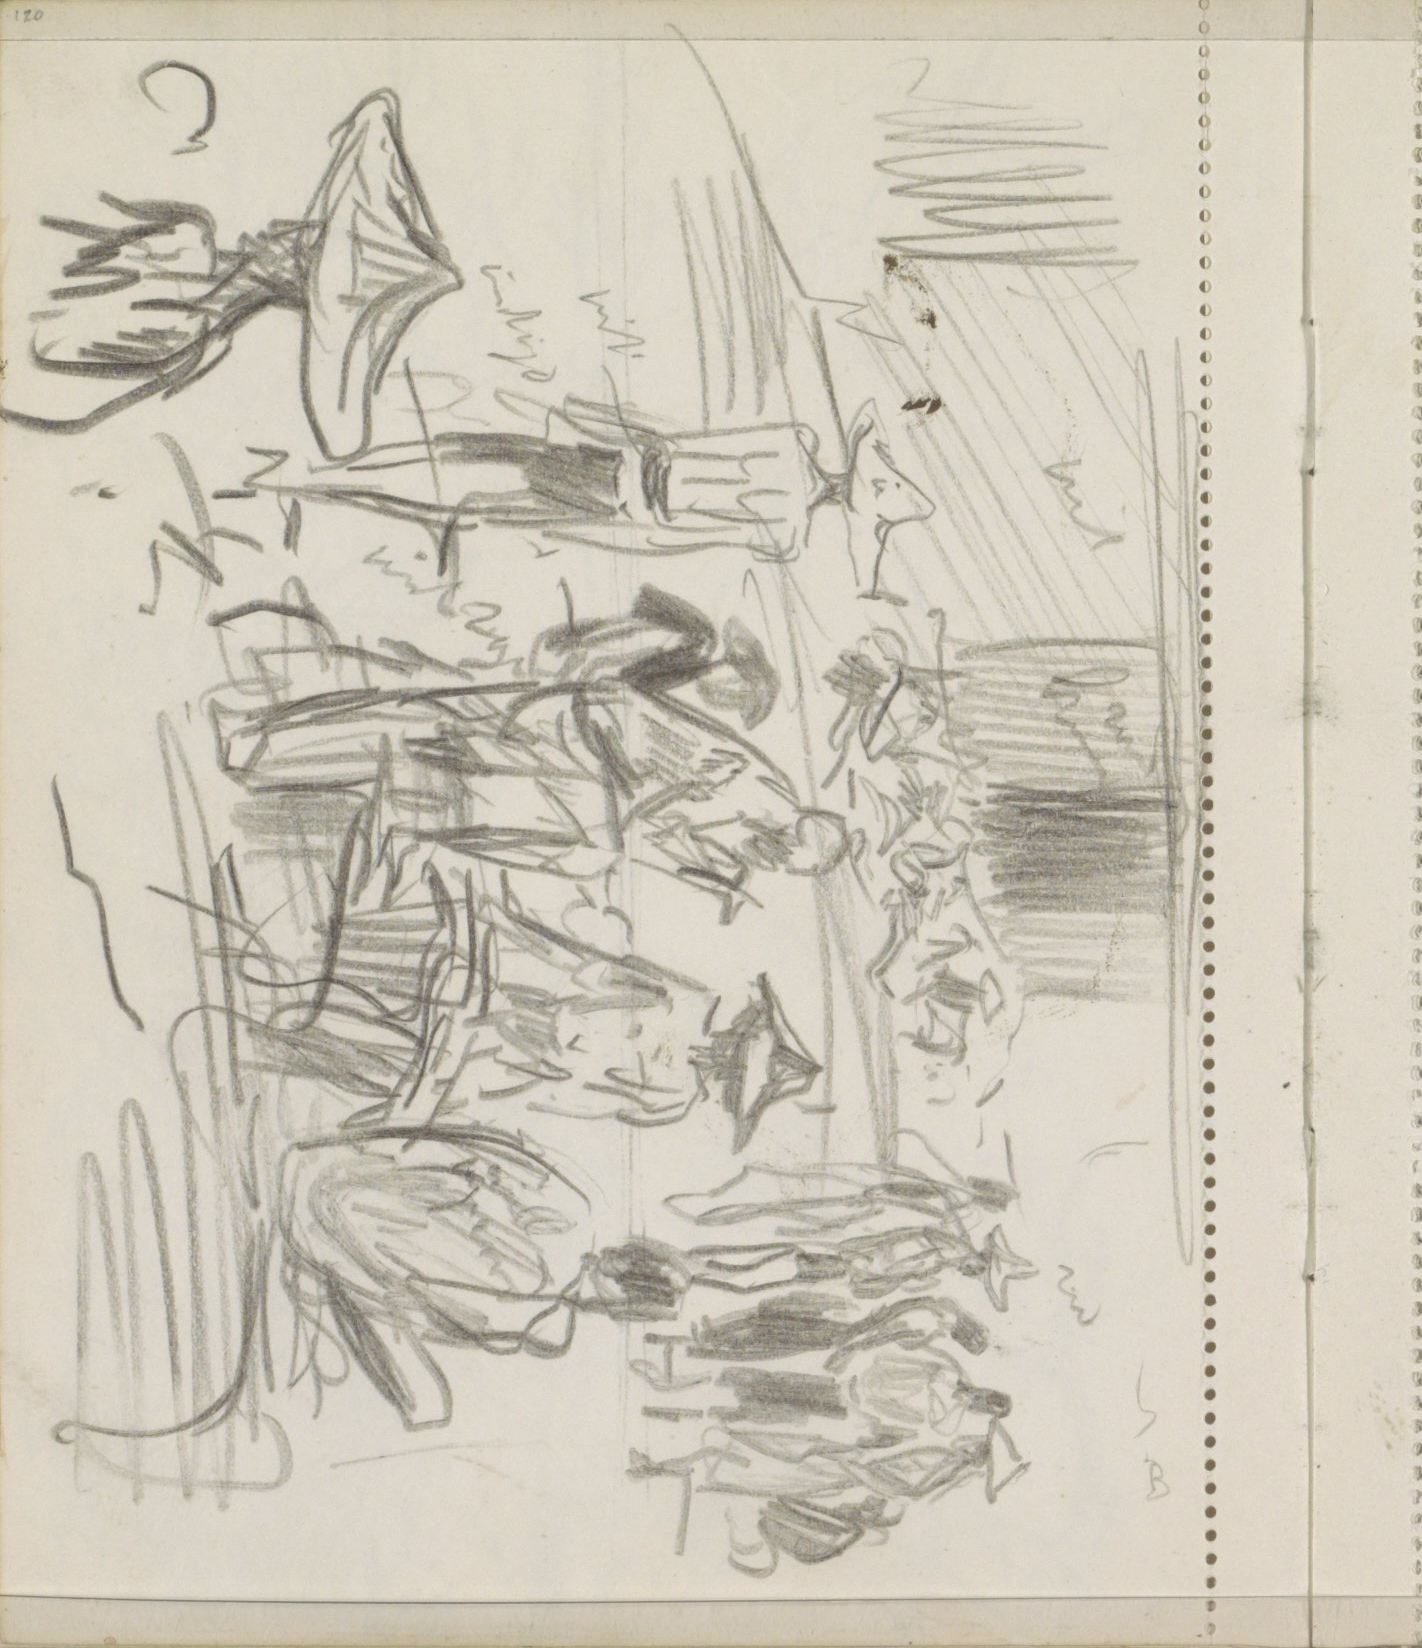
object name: sketchbook leaf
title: Indonesiërs op een straat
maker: marius bauer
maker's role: draughtsman, print maker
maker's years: 1867-1932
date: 1925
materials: chalk, paper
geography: indonesia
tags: asiatic races and peoples, folk costume, regional costume, street (+ city(-scape) with figures, staffage)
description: Enkele van de figuren dragen rieten hoeden. Pagina 120 uit een schetsboek met 67 bladen.